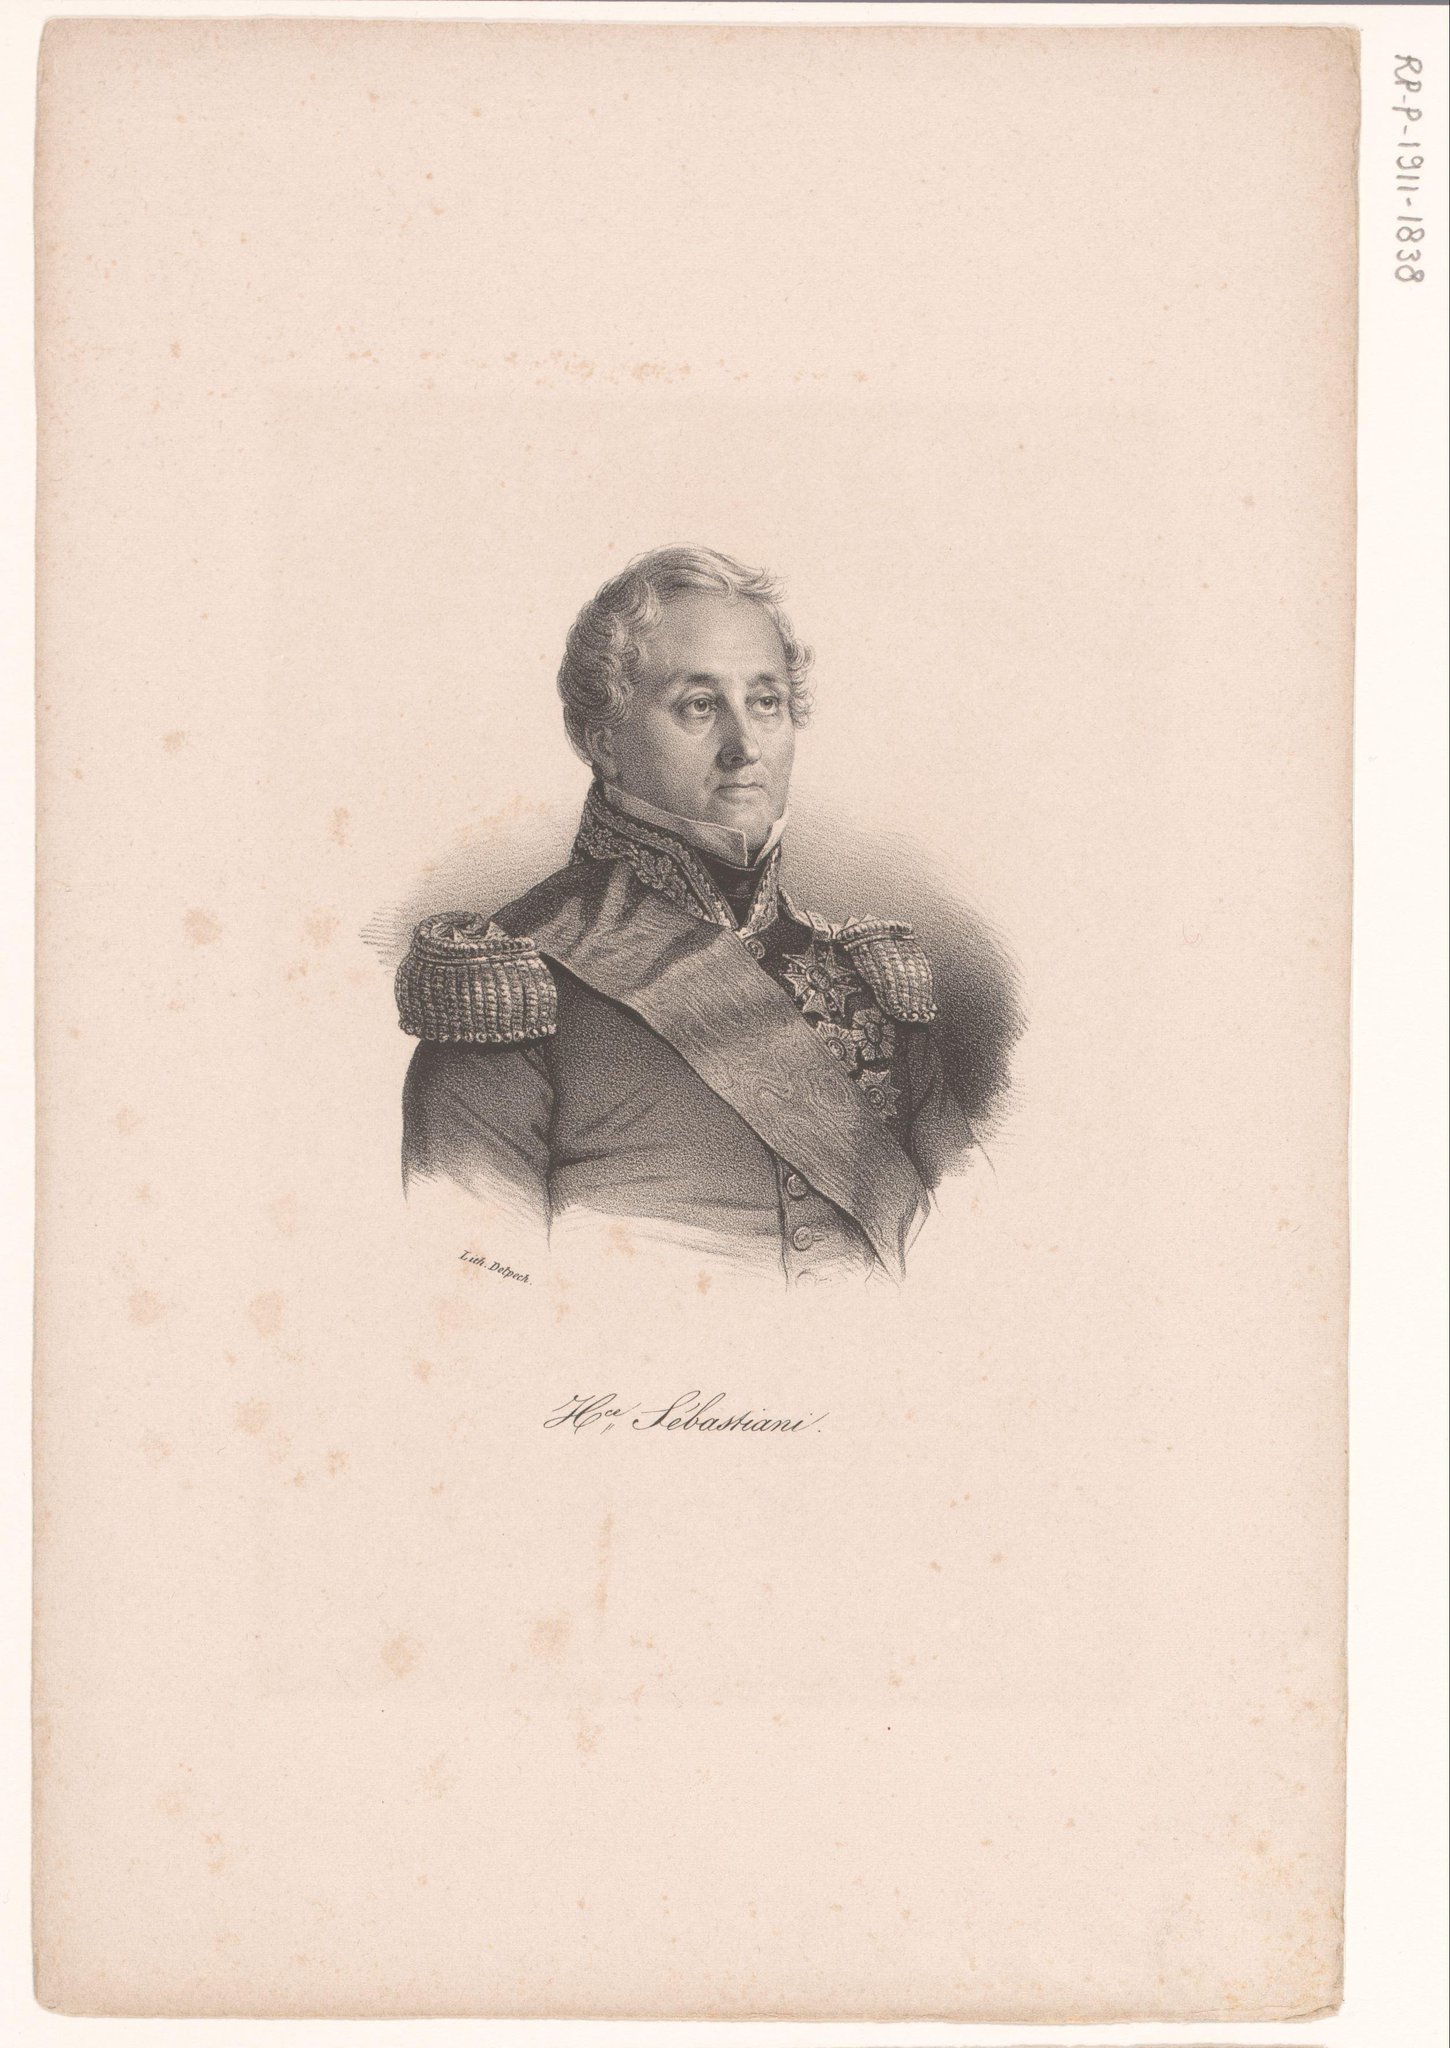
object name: print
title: H.ce Sébastiani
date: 1818-1842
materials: paper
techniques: lithograph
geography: paris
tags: paris, politician, historical persons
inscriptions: collector's mark: Lugt 2228a